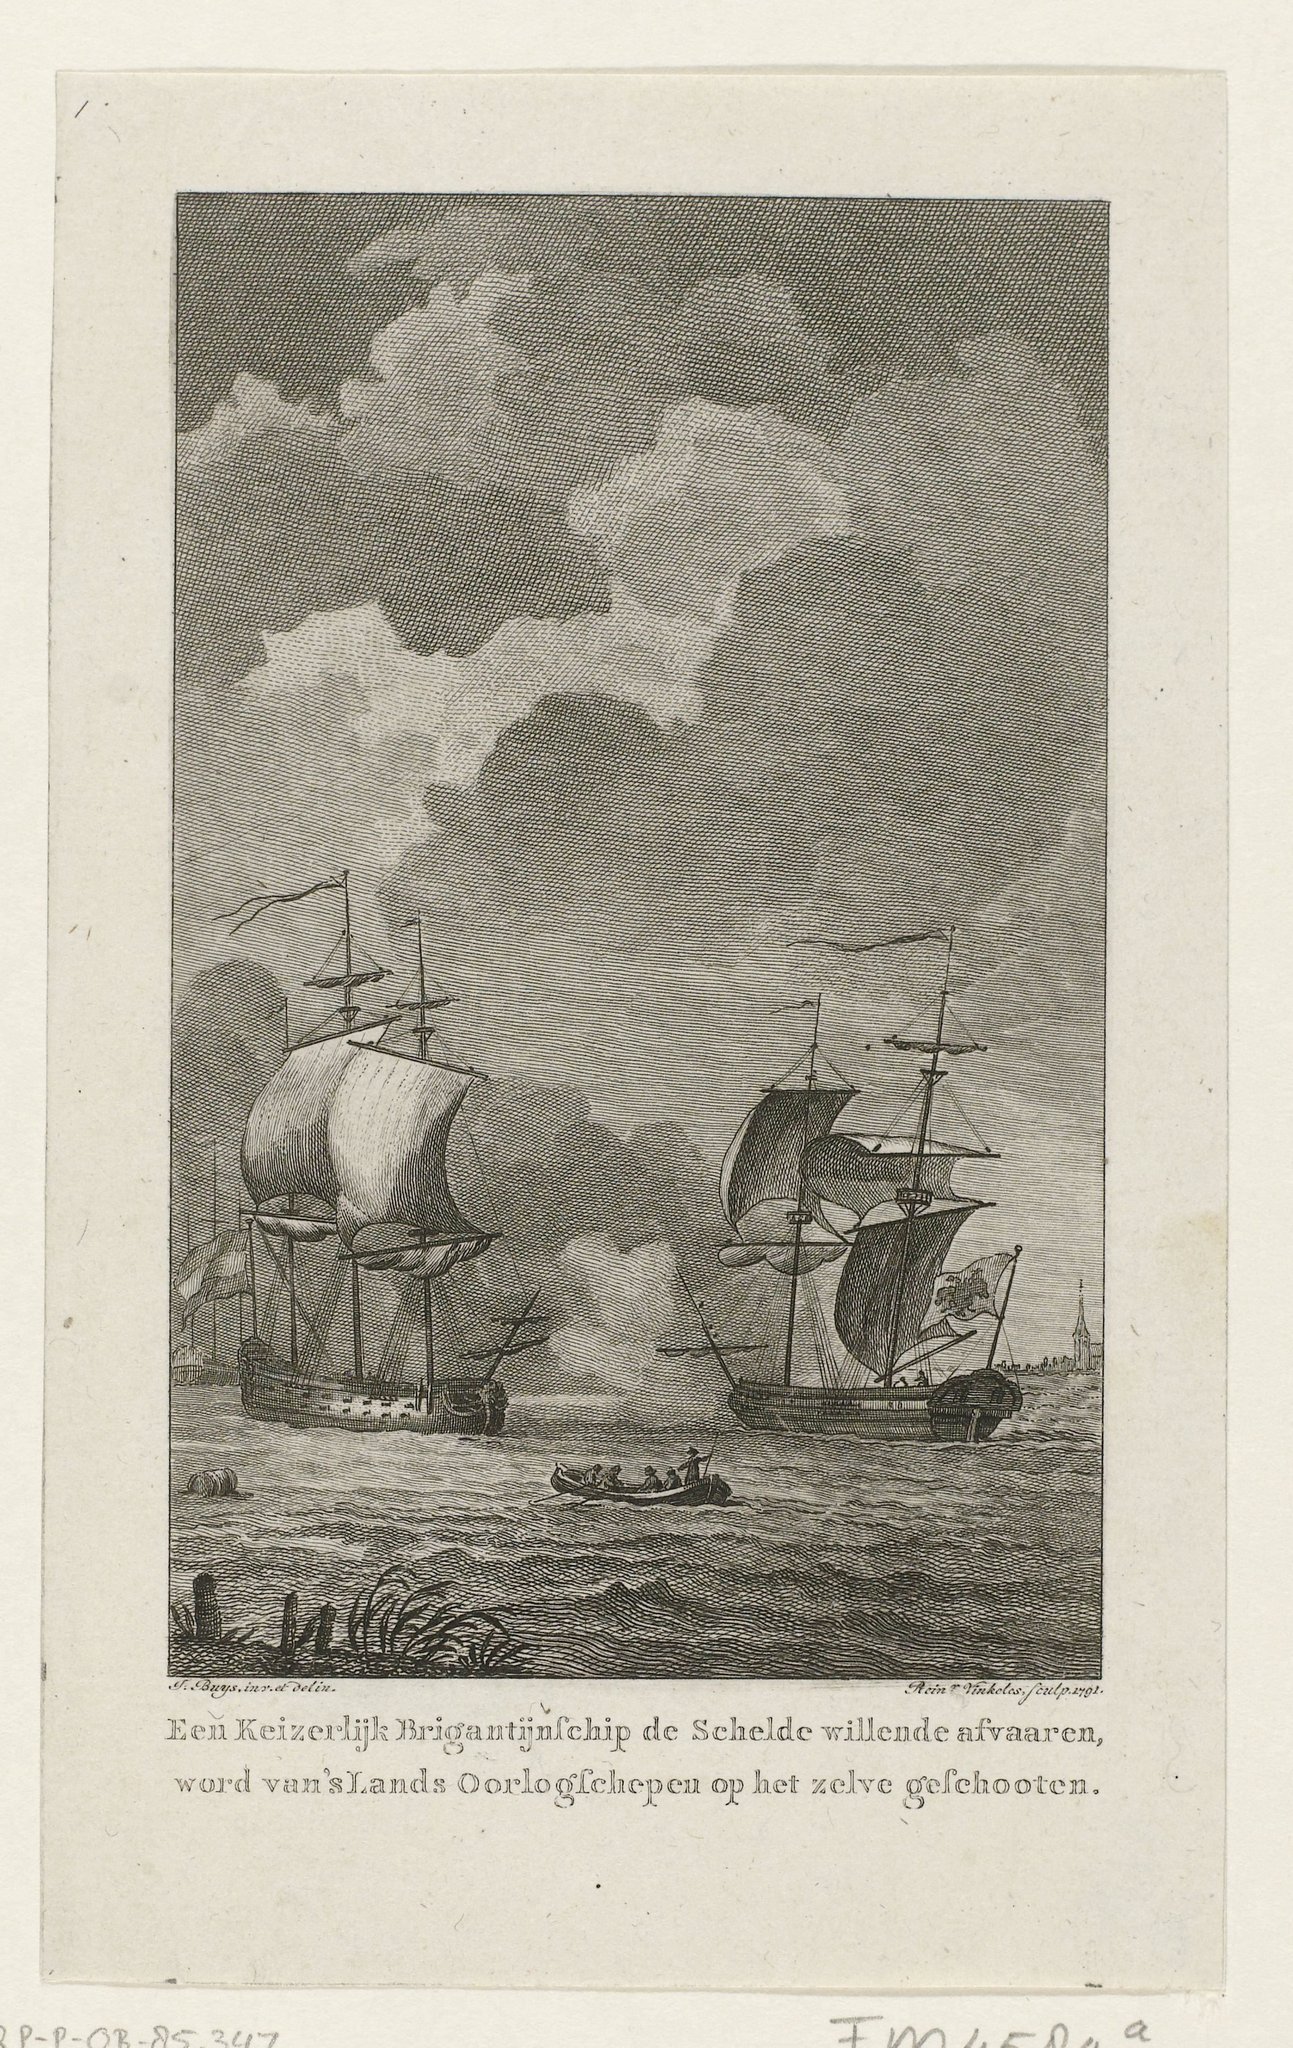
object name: print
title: Tegenhouden van de keizerlijke brik op de Schelde, 1784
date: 1791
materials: paper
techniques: engraving, etching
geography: northern netherlands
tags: battle (+ sailing-ships)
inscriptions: collector's mark: Lugt 2228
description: Het tegenhouden van de Oostenrijkse keizerlijke brik de Louis die de Schelde wilde opvaren door de Nederlandse schoener de Dolphijn onder commando van luitenant Tobias Tak Cuperus, 8 oktober 1784. Het Nederlandse schip vuurt een waarschuwingsschot. De incidenten op deze dag worden aangeduid met de spotnaam de Keteloorlog.